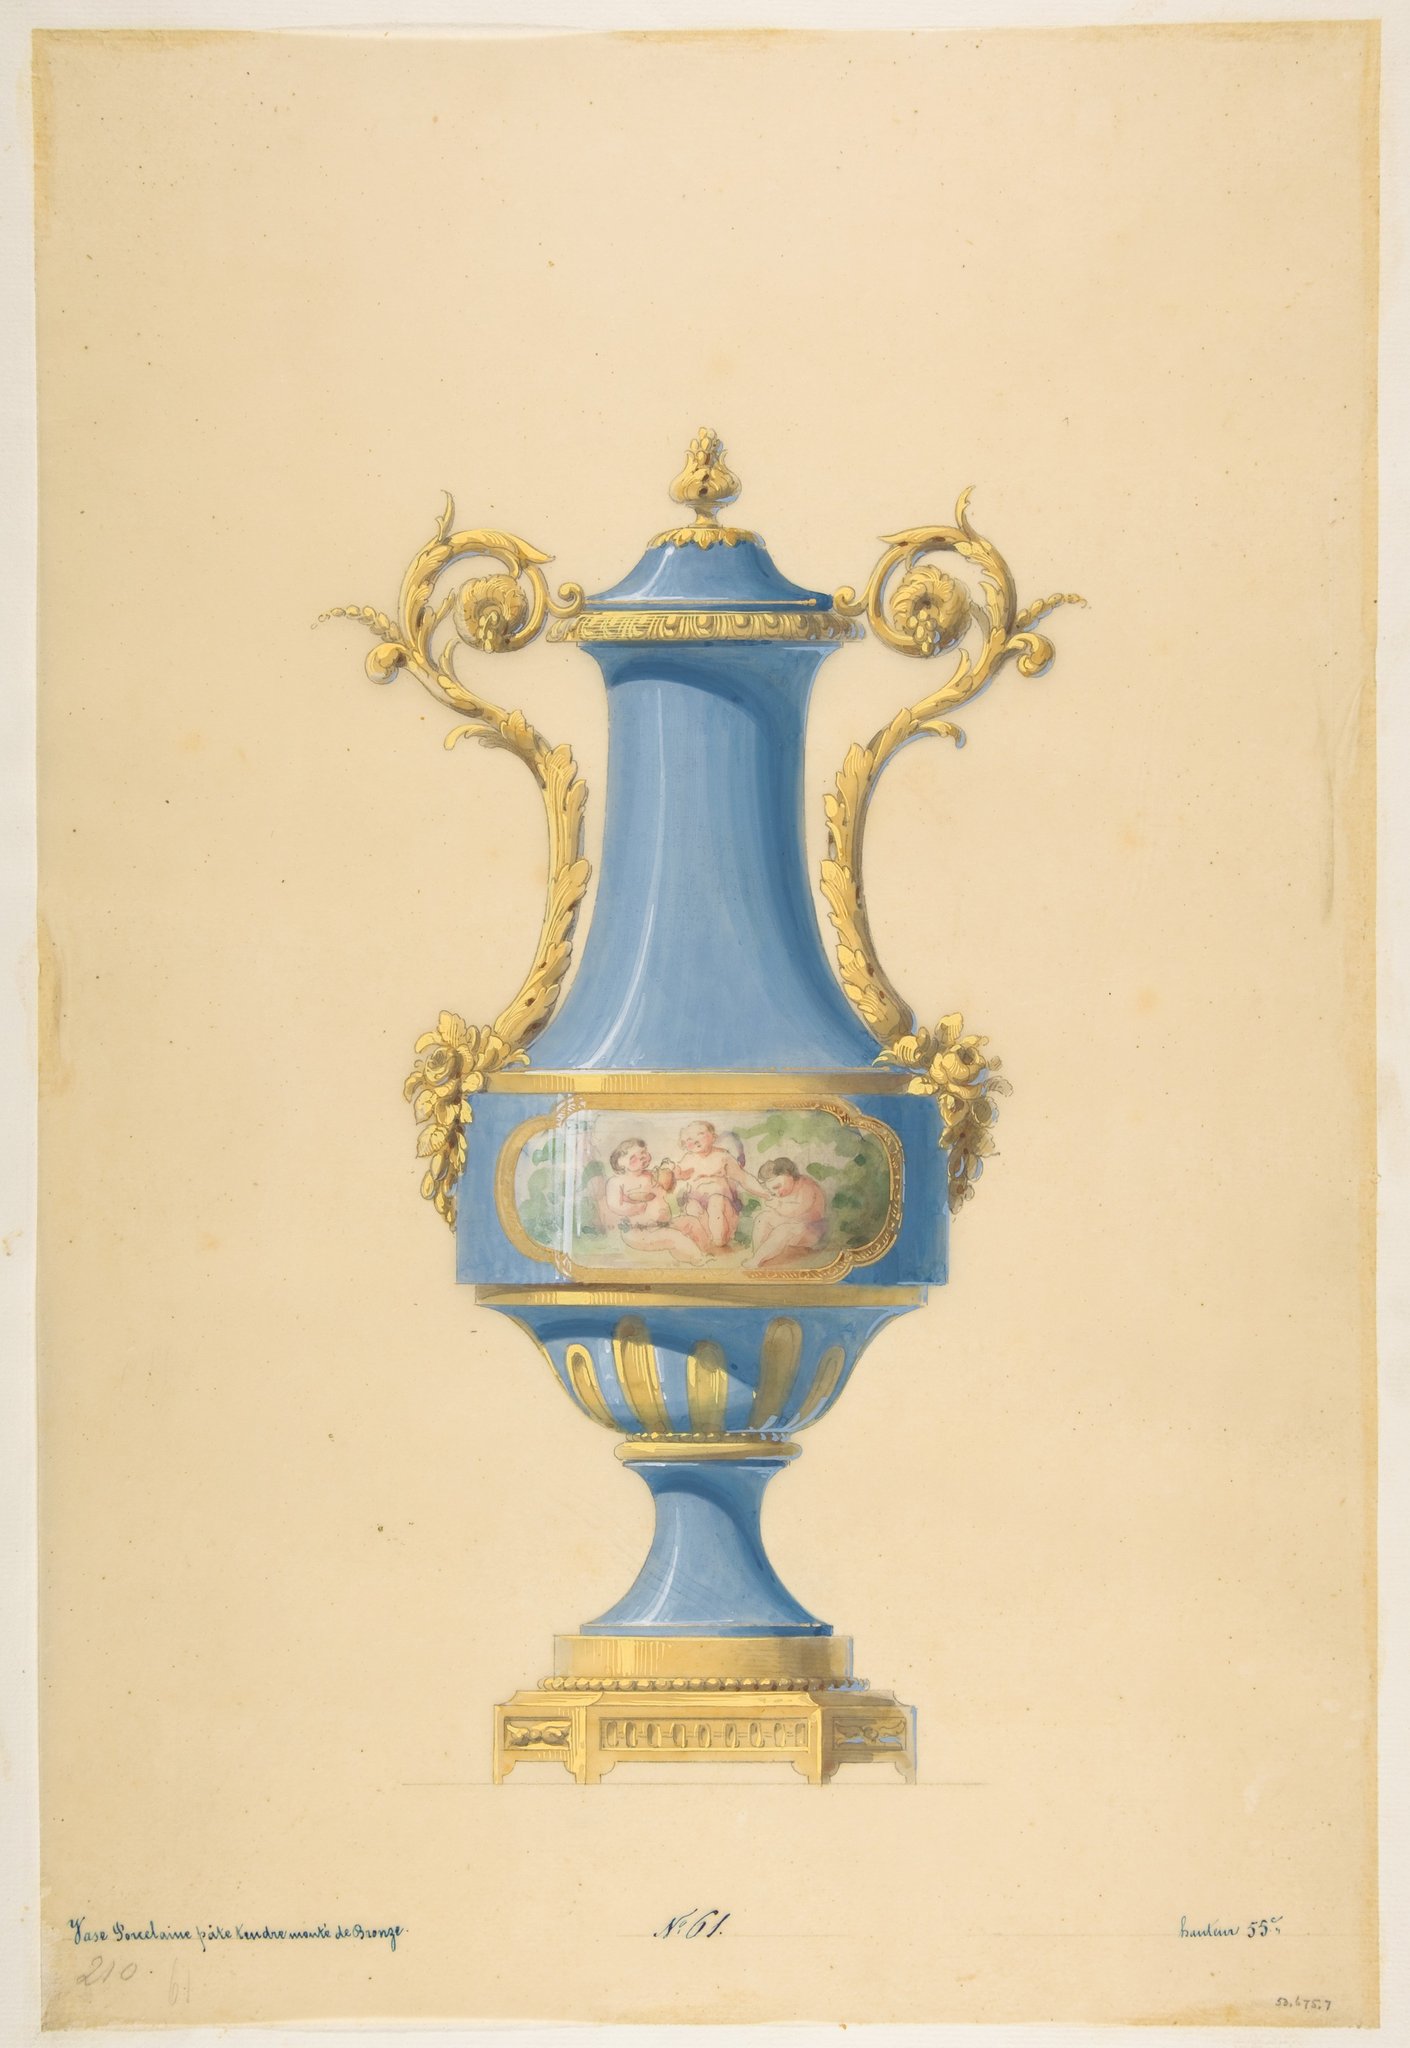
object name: drawing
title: Design for a Porcelain Vase with Bronze Mount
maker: anonymous, french, 19th century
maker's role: artist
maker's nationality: french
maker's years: 1800-1900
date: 1801-1900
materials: gilt, gold, gouache, graphite, watercolor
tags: children,flowers,leaves,vases